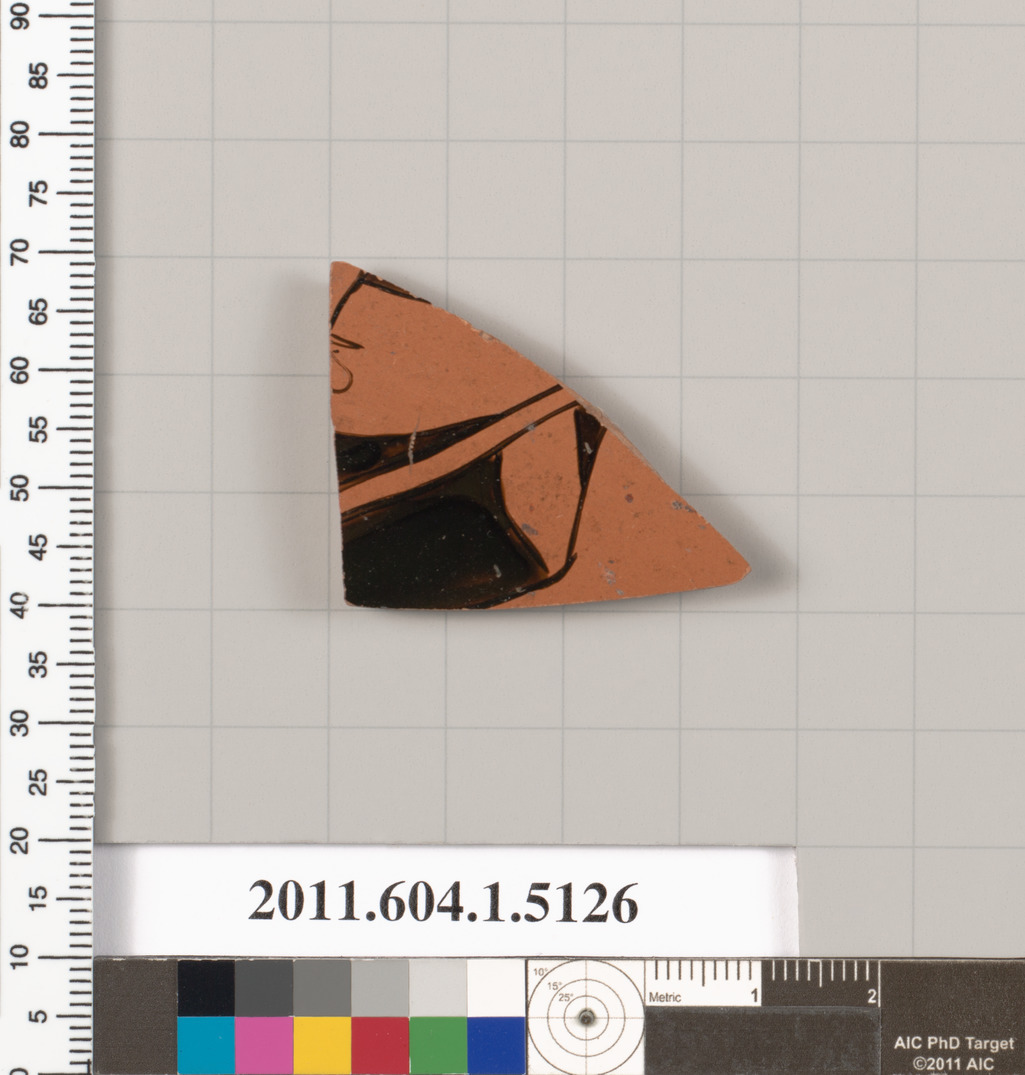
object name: kylix fragment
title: Terracotta fragment of a kylix (drinking cup)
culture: greek, attic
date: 490-480 BCE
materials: terracotta